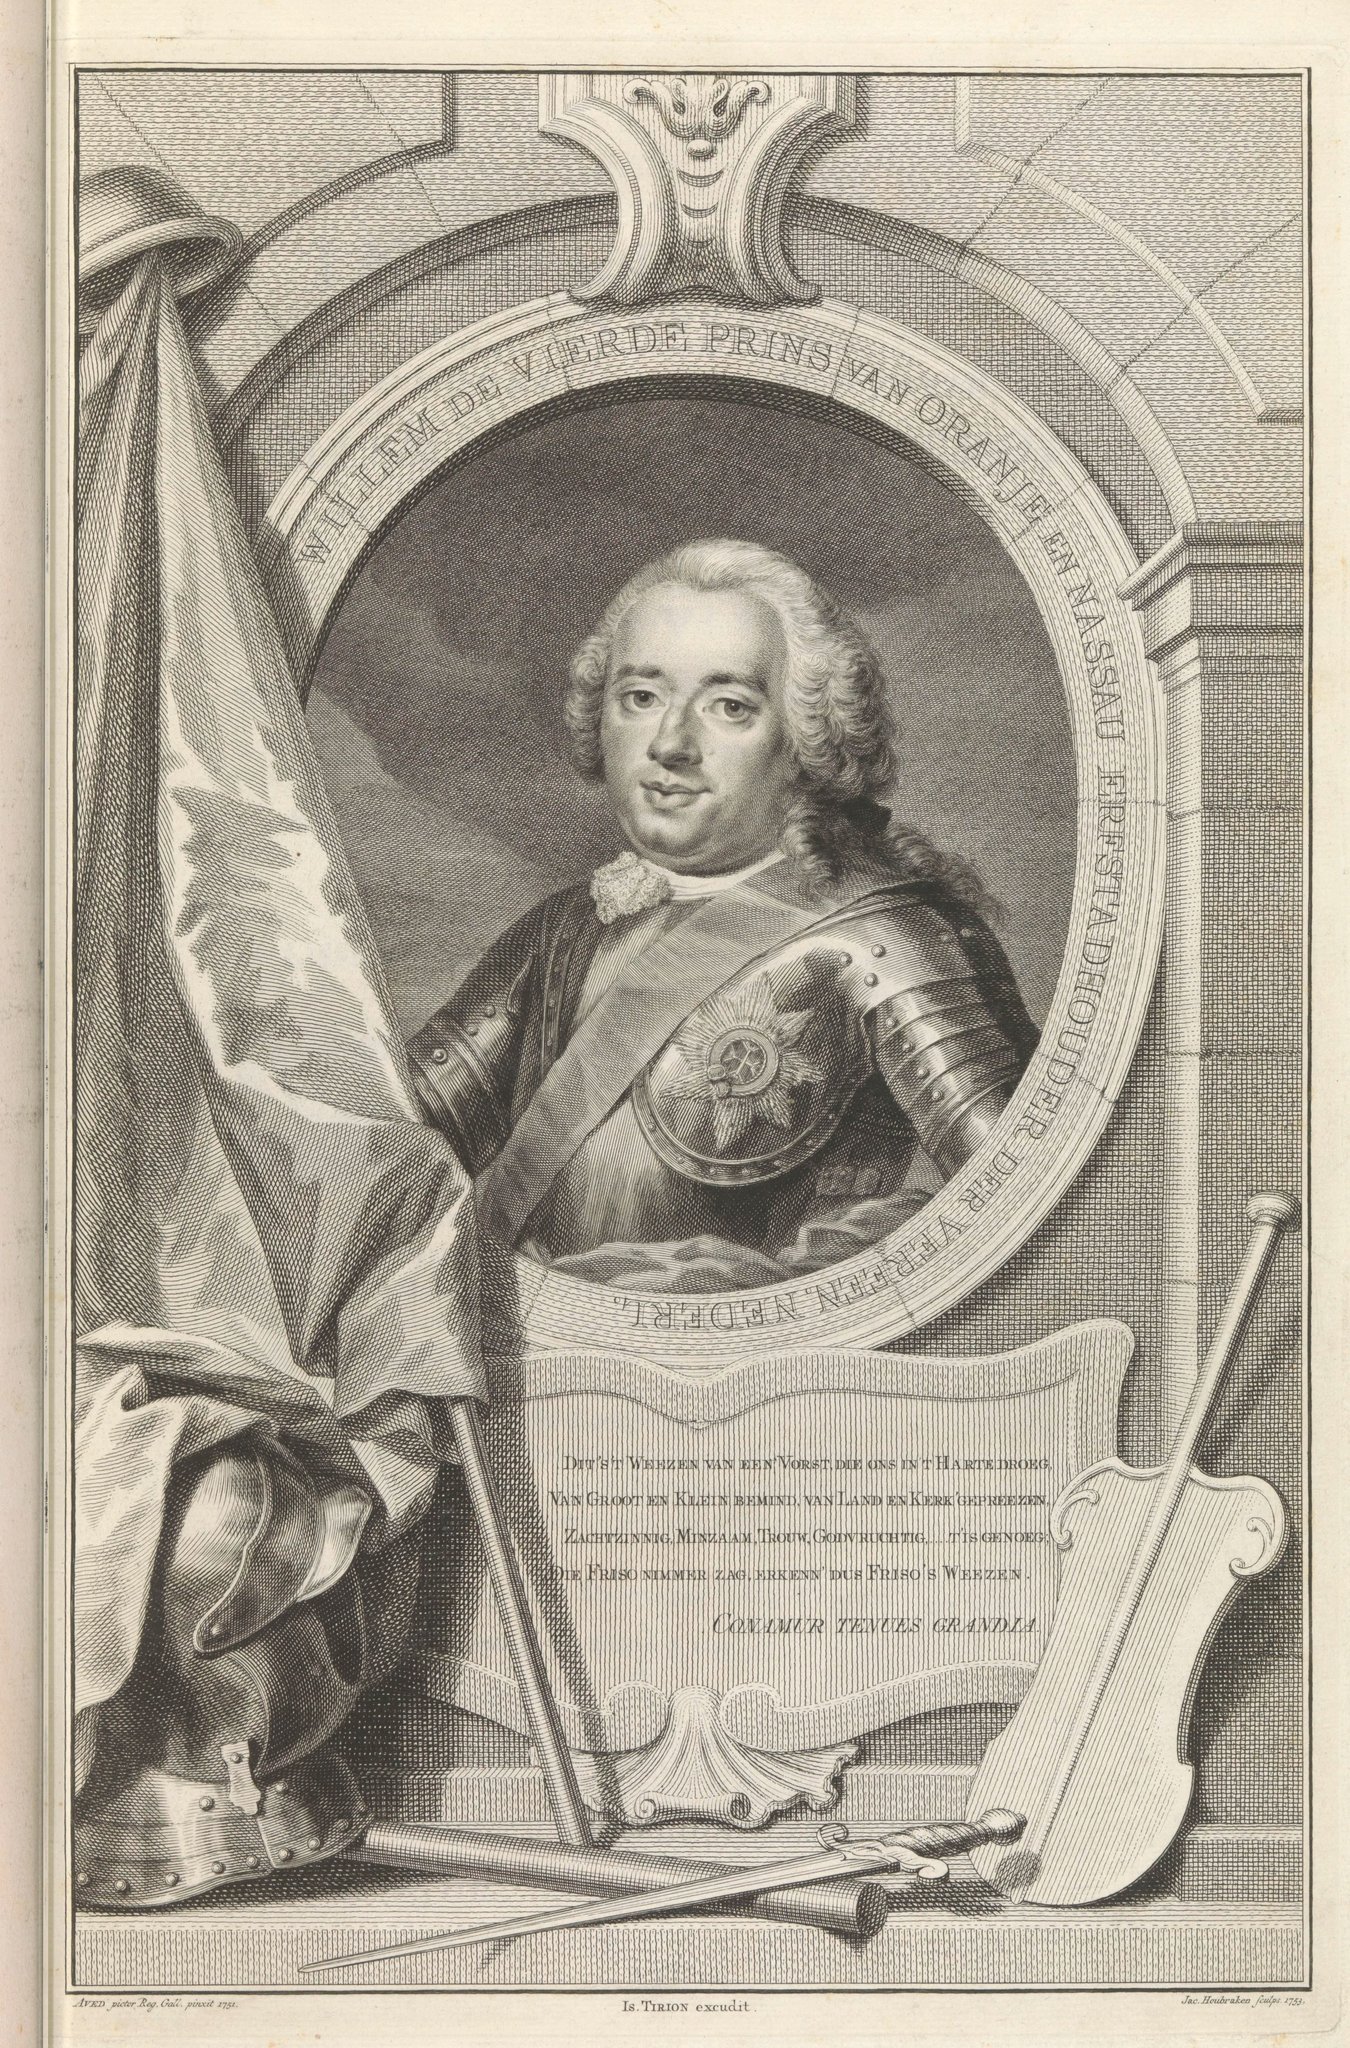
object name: book illustration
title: Portret van Willem IV, 1751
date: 1753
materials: paper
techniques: engraving, etching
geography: northern netherlands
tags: the hague, willem iv (prins van oranje-nassau), flushing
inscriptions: collector's mark: Lugt 2166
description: Portret van standhouder Willem IV in wapenrusting, ovaal in een stenen muur. Voor het portret een vaandel, helm, roer en dolk. Onder het portret een vers door het Vlissingse dichtersgenootschap 'Conamur tenues grandia'. Illustratie in het boek over de inhuldiging van Willem IV als erfheer van Vlissingen op 5 juni 1751.